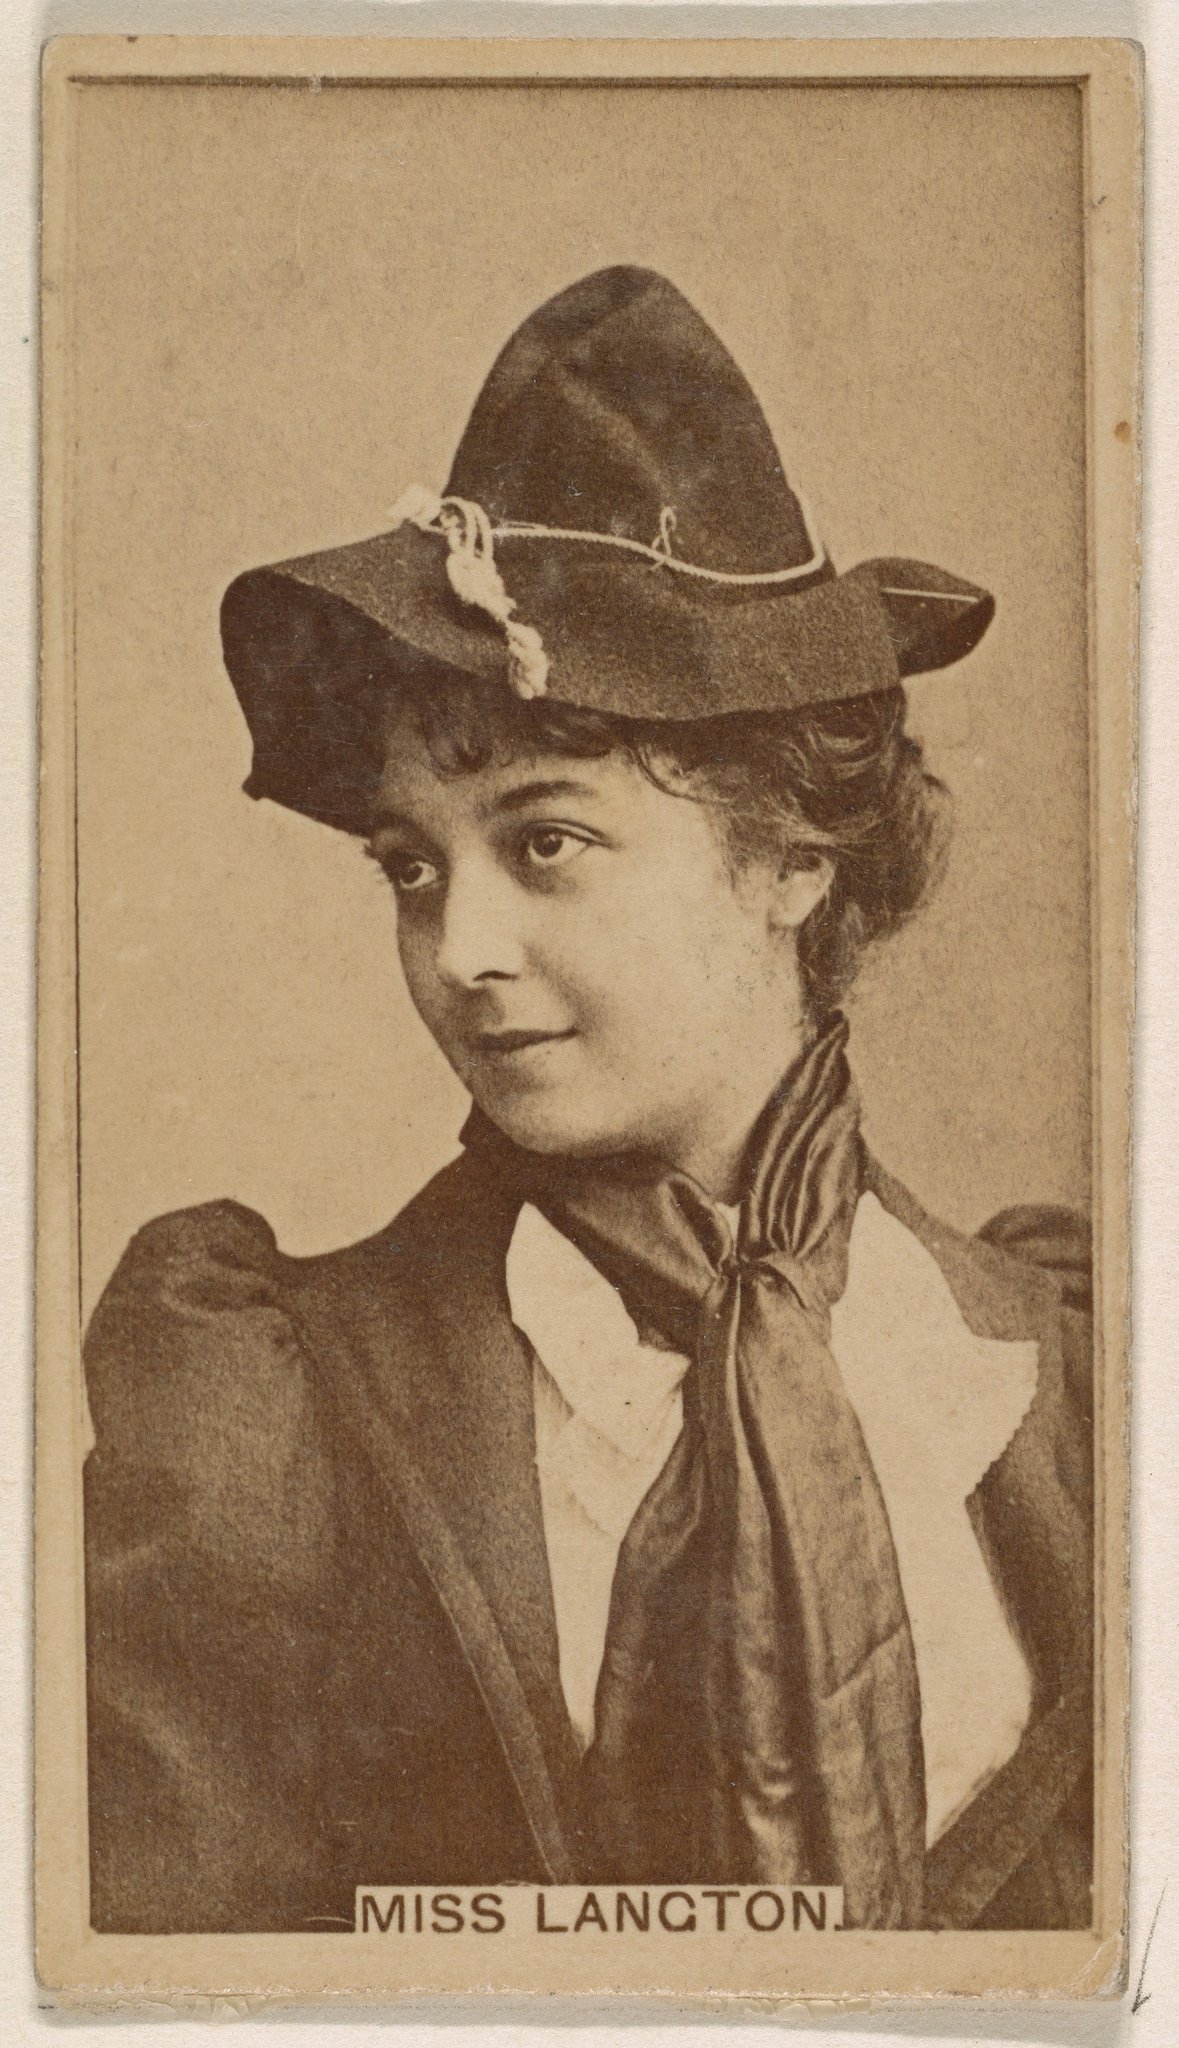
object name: photograph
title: Miss Langton, from the Actresses series (N245) issued by Kinney Brothers to promote Sweet Caporal Cigarettes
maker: kinney brothers tobacco company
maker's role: publisher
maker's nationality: american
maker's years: 1869-2011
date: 1890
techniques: albumen silver print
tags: portraits,women,actresses